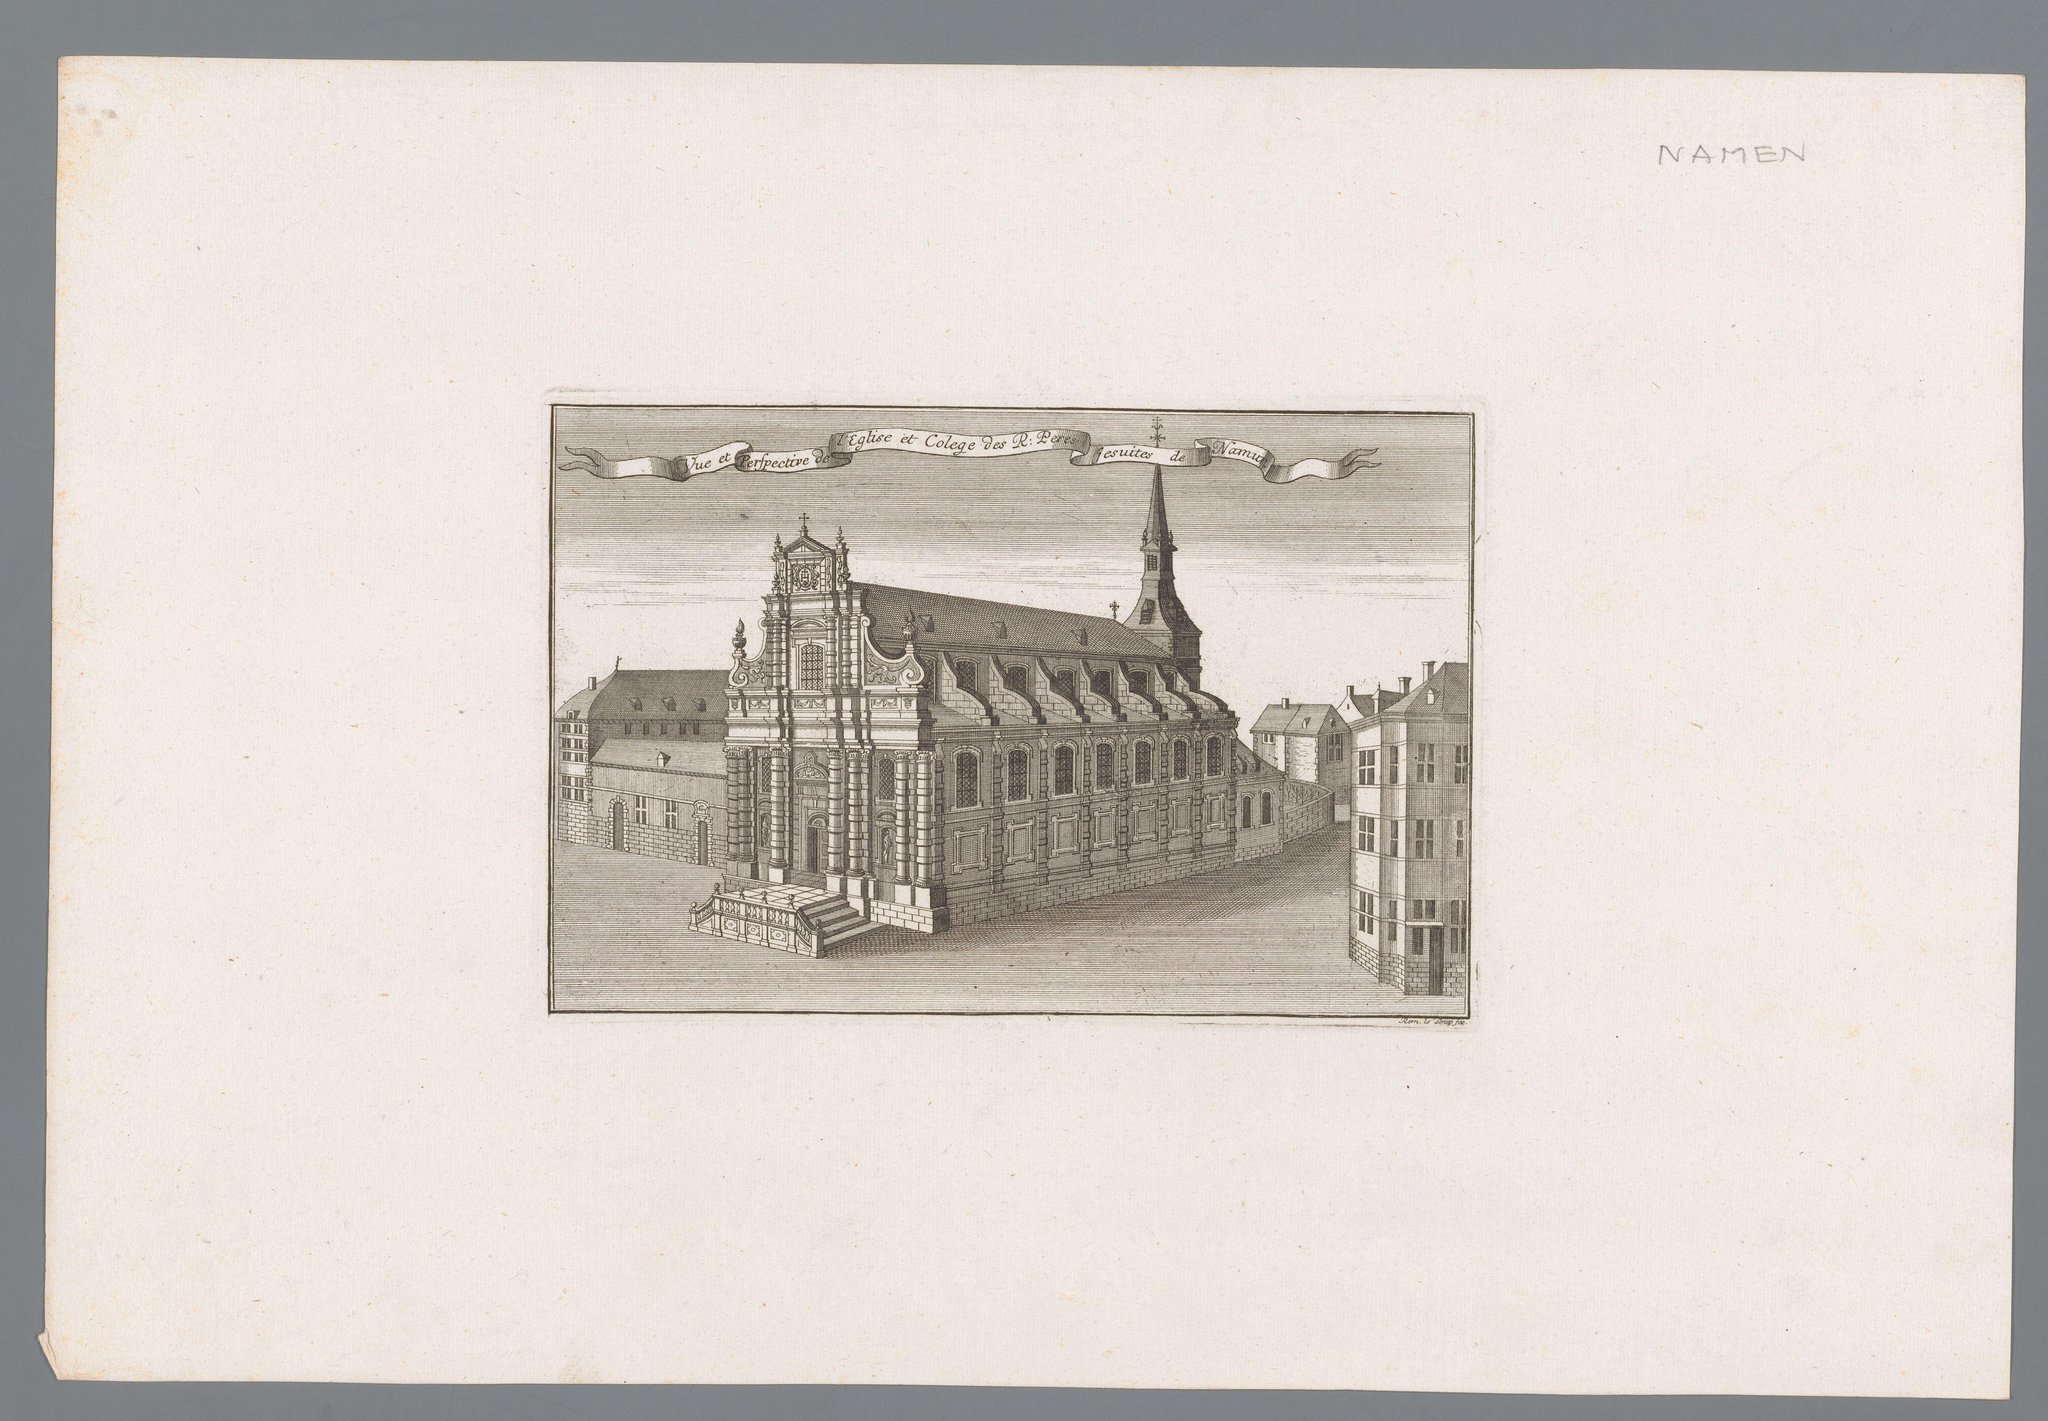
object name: print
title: Vue et perspective de l'eglise et colege des R: peres Jesuites de Namur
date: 1738-1744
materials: paper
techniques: engraving, etching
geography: liège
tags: church (exterior), regular clerics, e.g. jesuits, redemptorists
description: Prent uit: Johanne de Saumery, Alexandre de et al. Les délices du païs de Liège, ou description géographique, topographique et chorographique des monumes sacrés et profanes (...). 5 dln. Luik: Everard Kints, 1738-1744, dl. 2, p. 187.